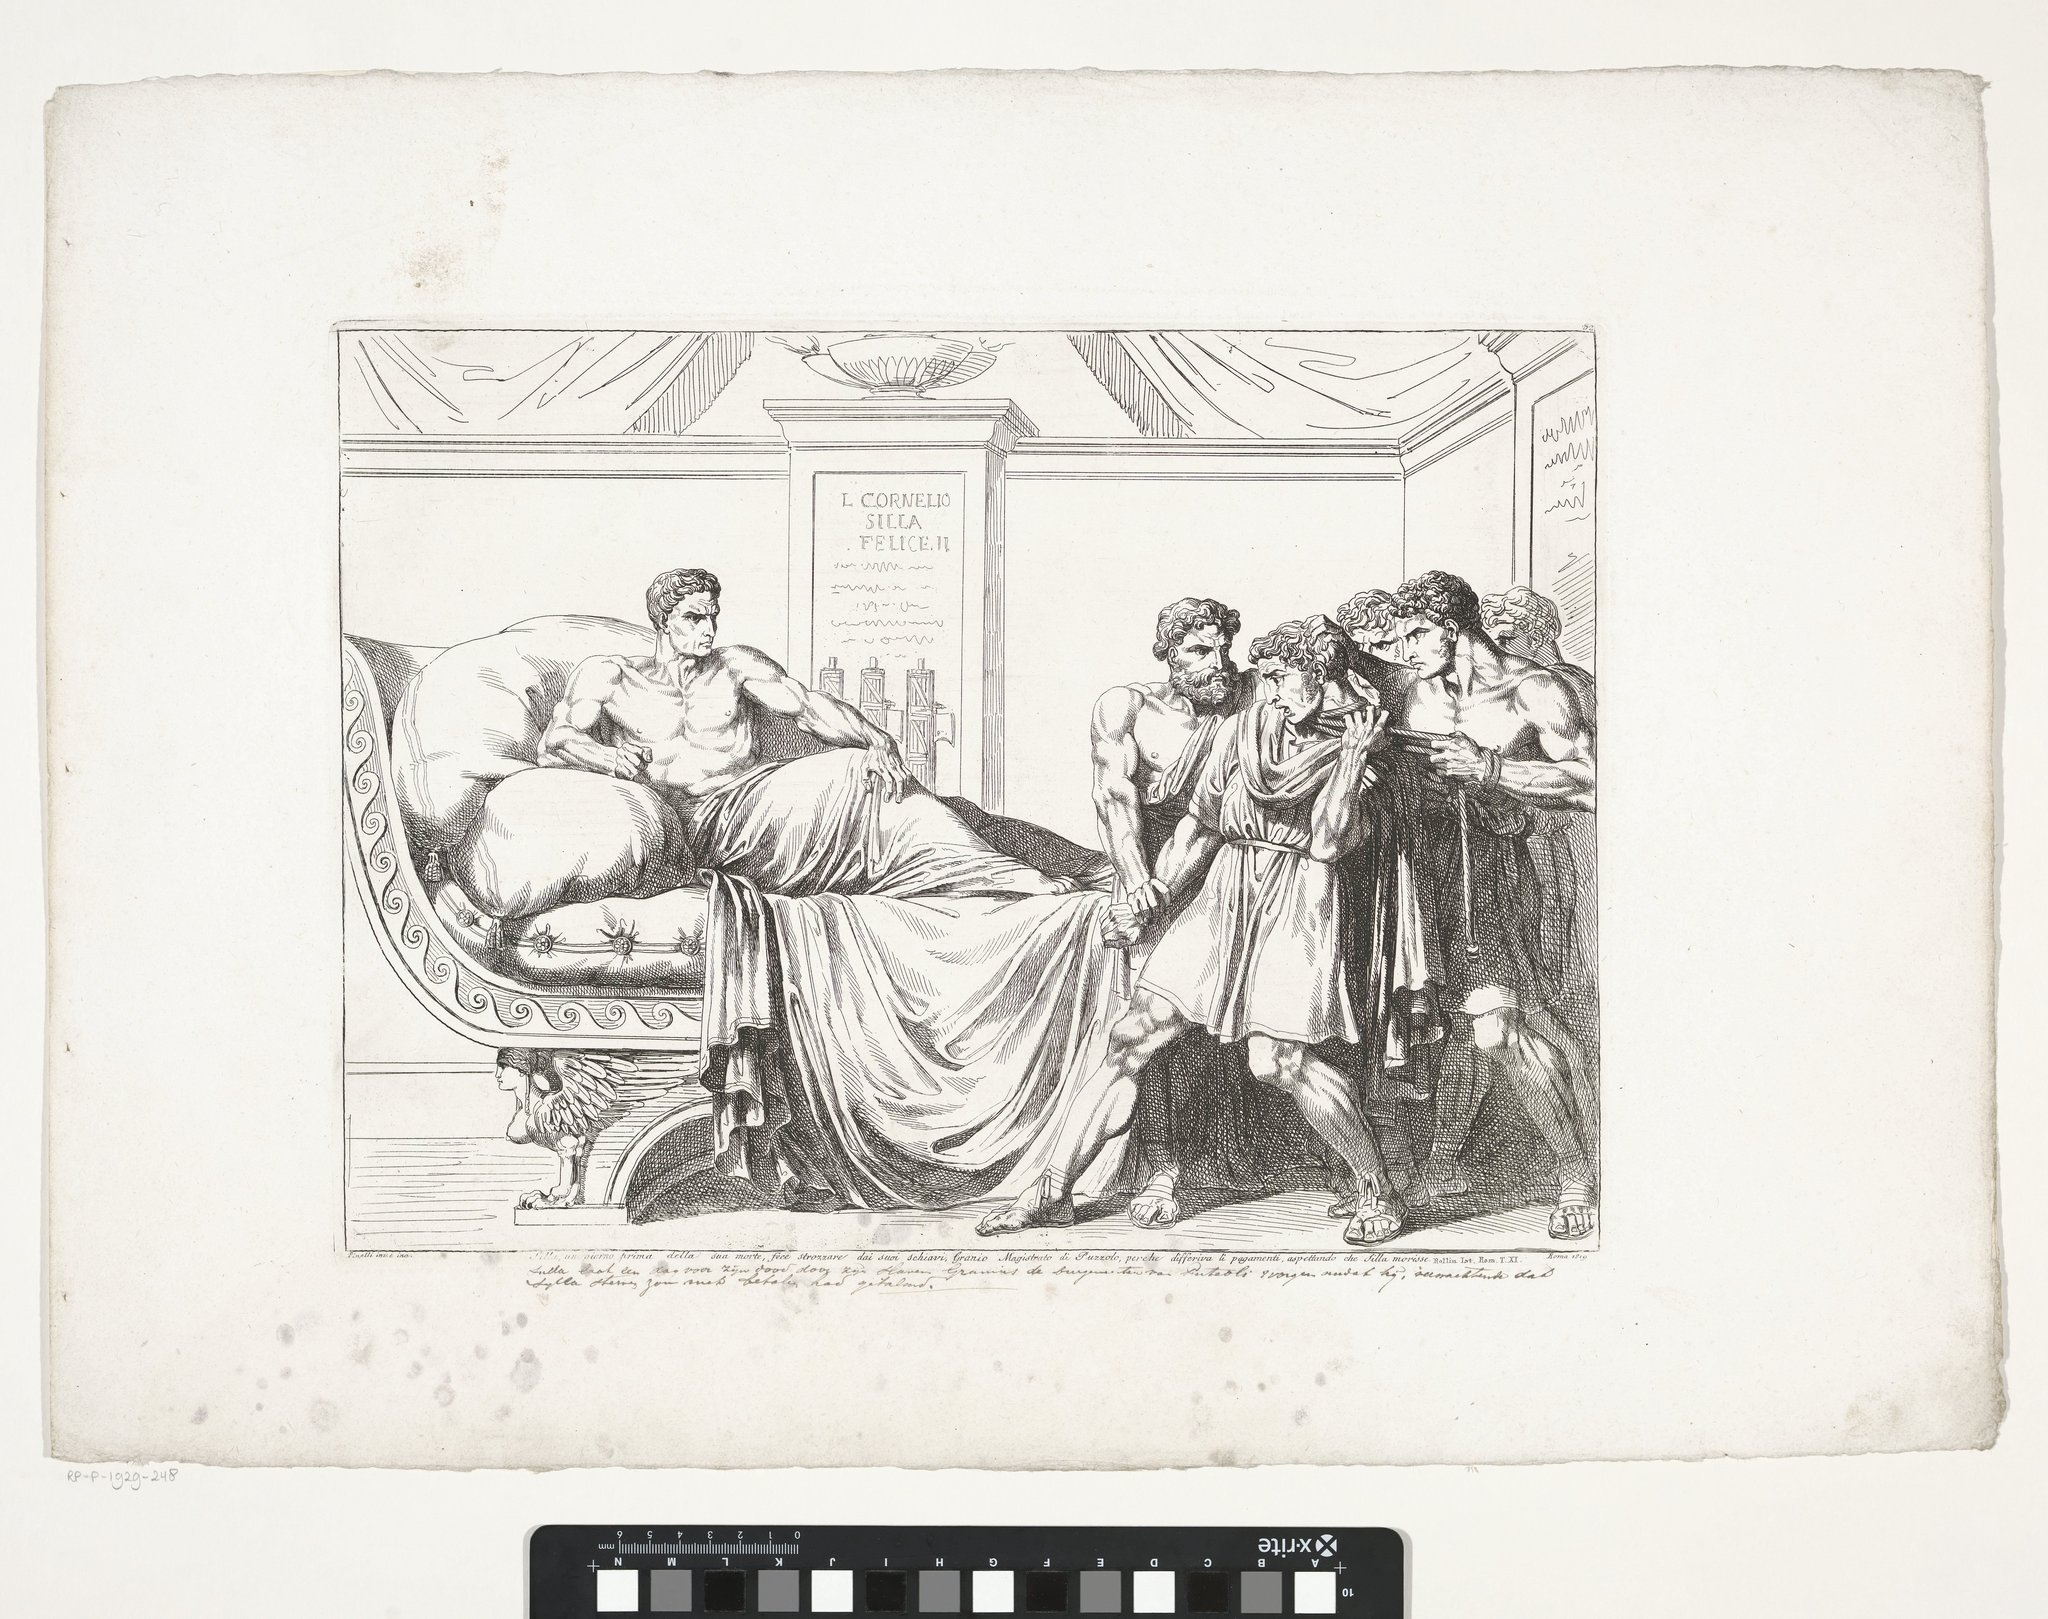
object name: print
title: Lucius Cornelius Sulla laat Granius voor zich brengen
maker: bartolomeo pinelli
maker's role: draughtsman, print maker, sculptor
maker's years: 1781-1835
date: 1819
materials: paper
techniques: etching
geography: rome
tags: history, slavery; serfs and enslaved persons, the soldier; the soldier's life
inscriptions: collector's mark: Lugt 2228, inscription: ‘Sulla laat een dag voor zijn dood...’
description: Lucius Cornelius Sulla ligt op een aanligbed en laat Granius voor zich brengen door zijn slaafgemaakten.